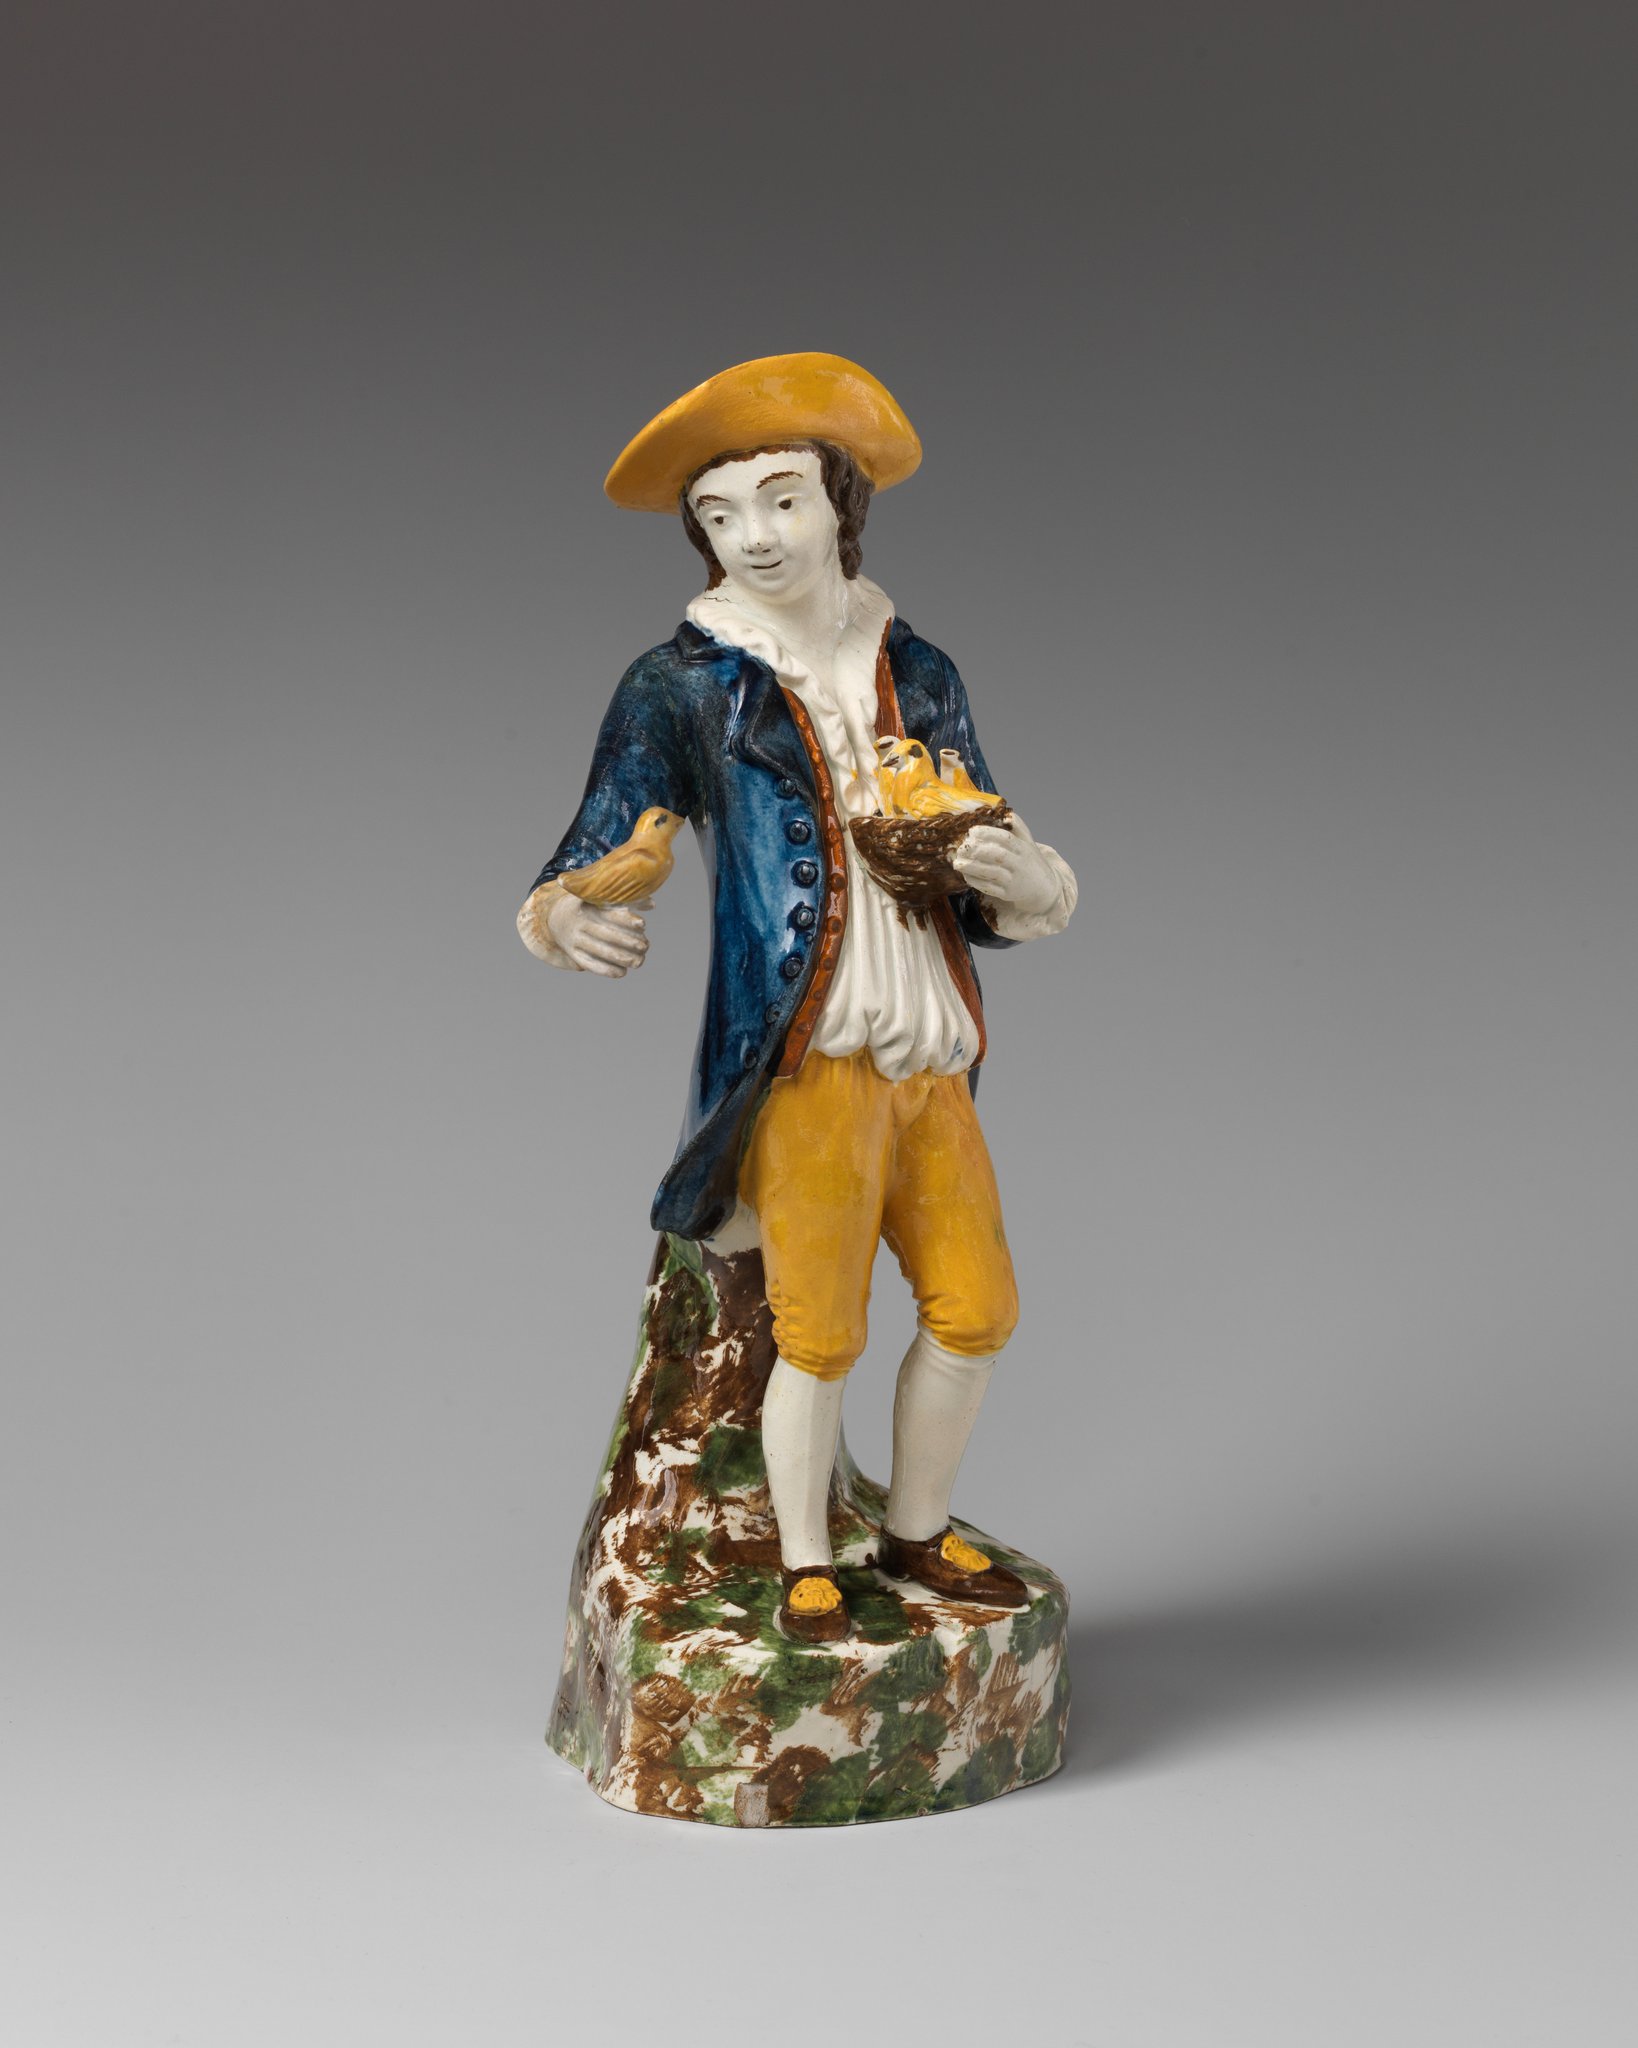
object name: figure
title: Boy (one of a pair)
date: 1780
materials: earthenware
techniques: glazing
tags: birds,boys